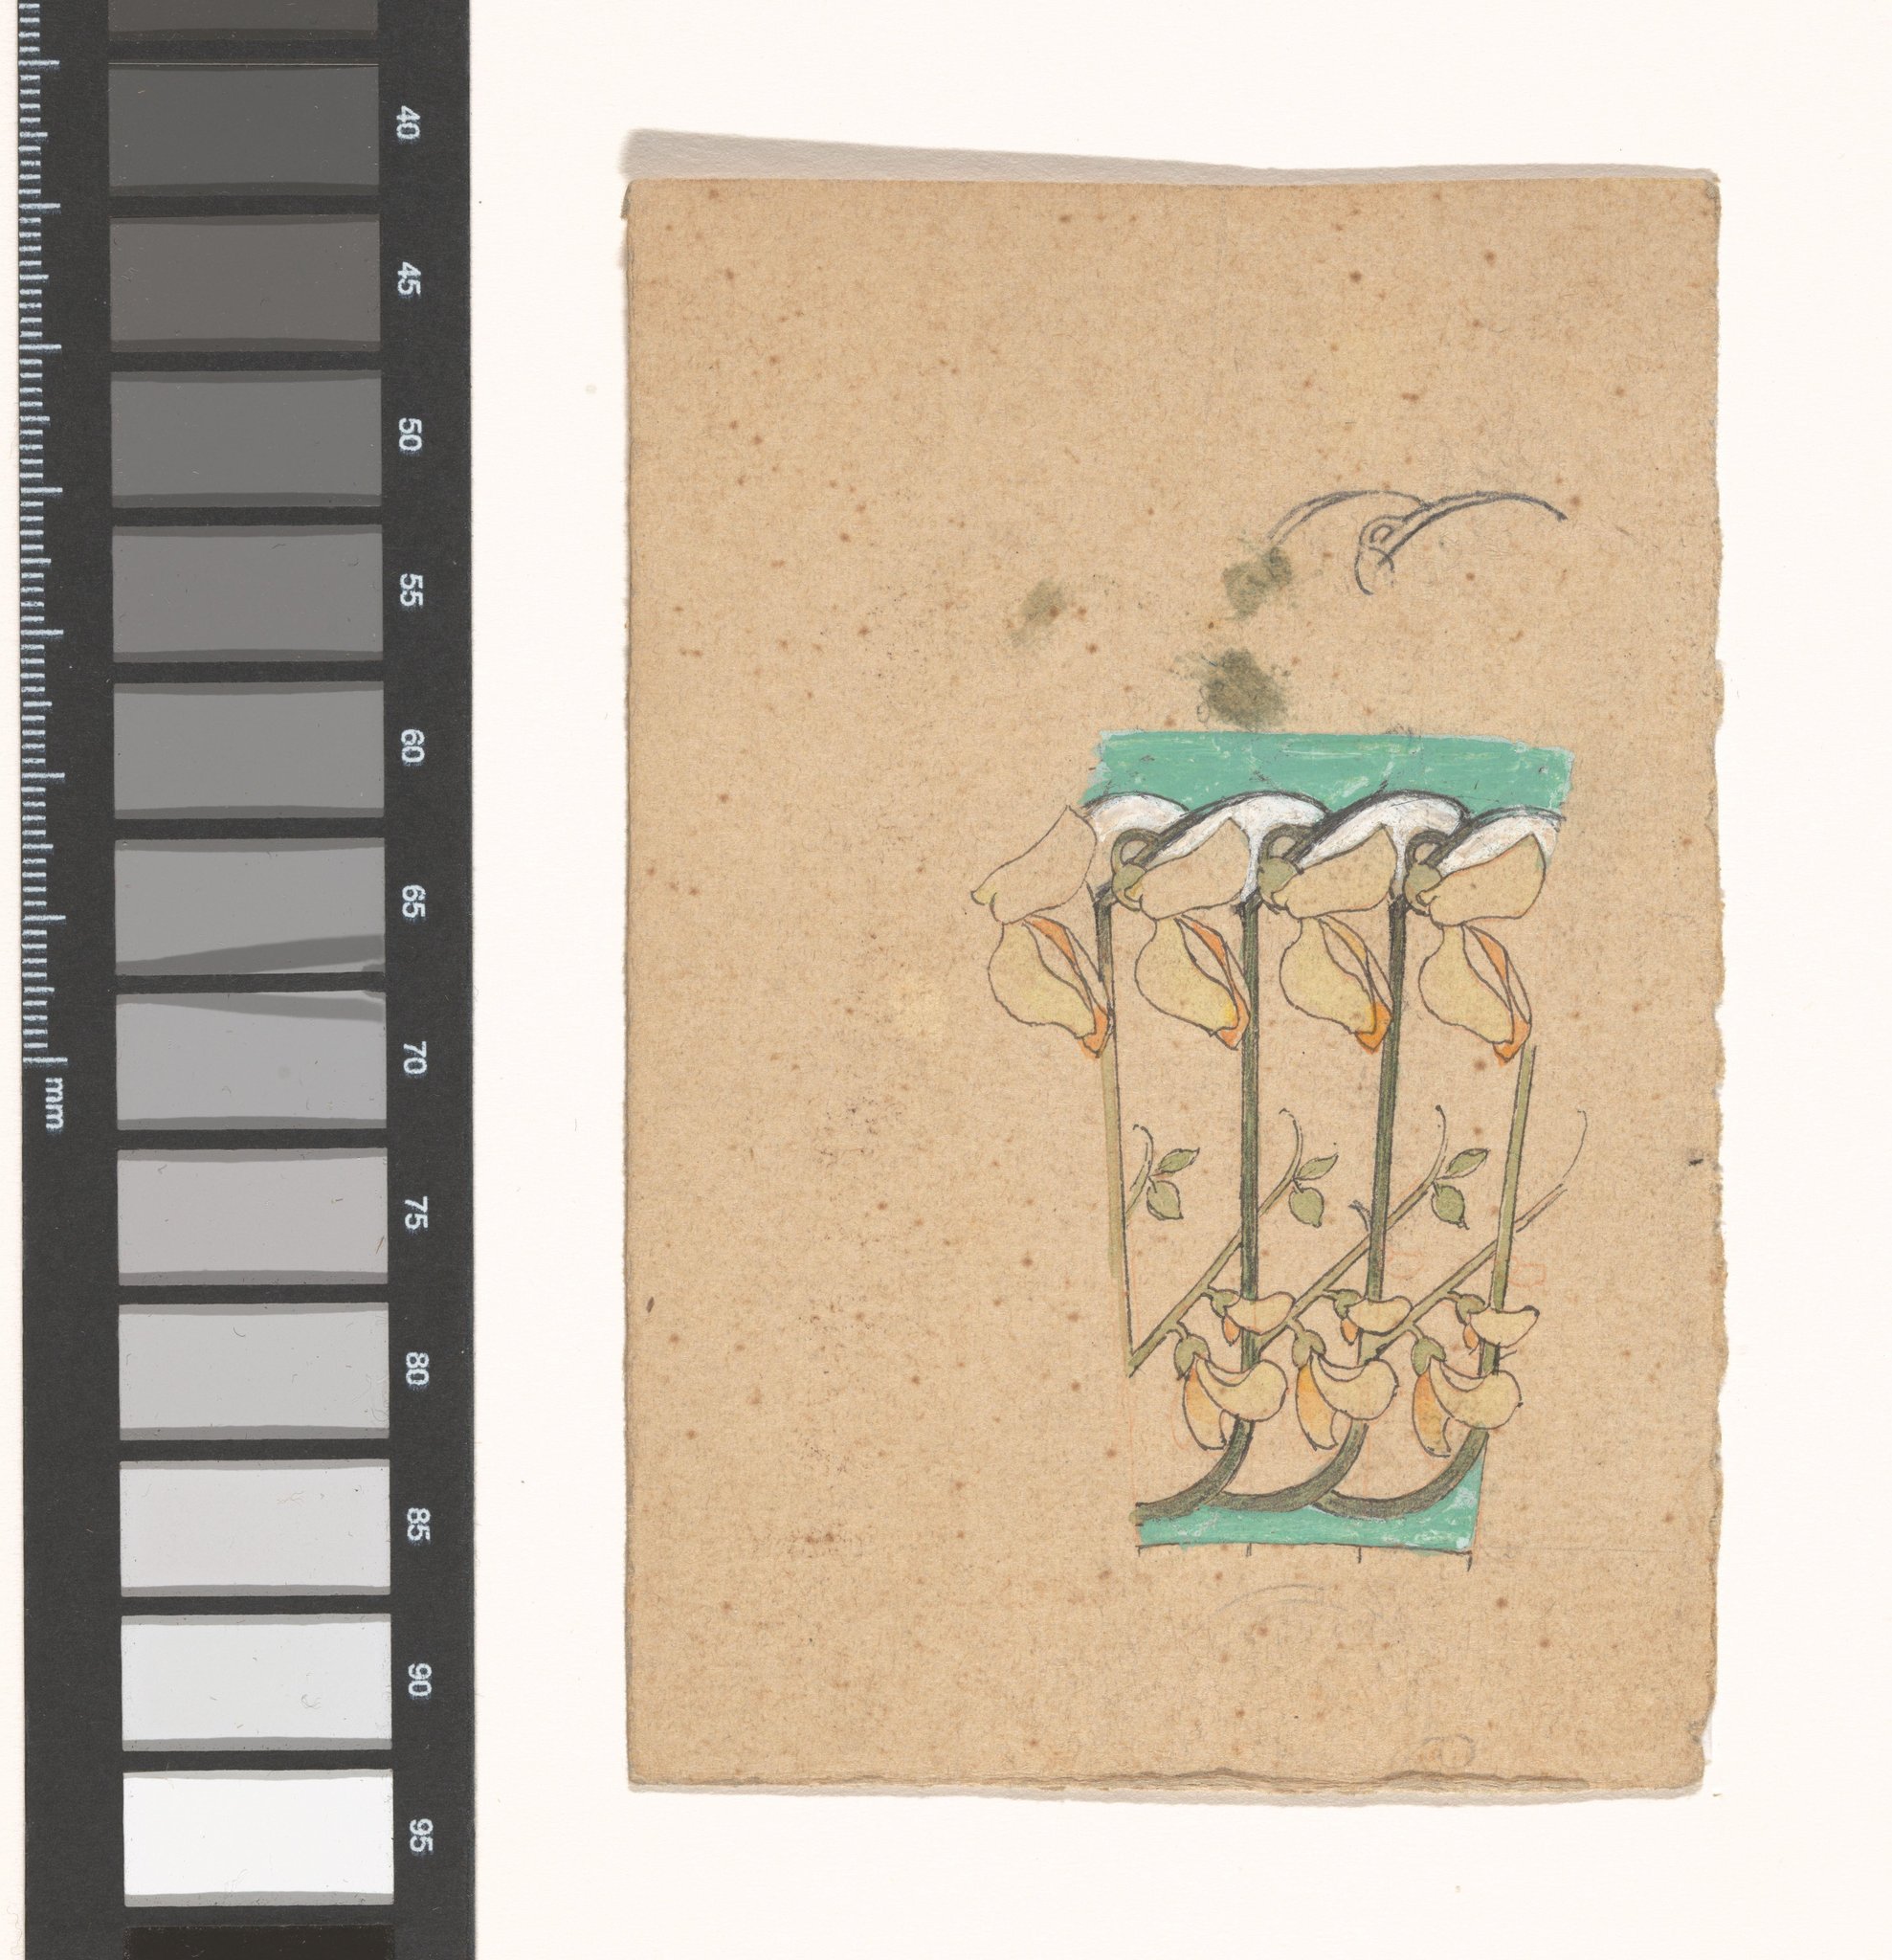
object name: design drawing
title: De beschildering met lathyrus van een knop, met daarboven enkele blaadjes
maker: anatole-alexis fournier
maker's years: 1864-1926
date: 1897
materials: paint, ink, paper, watercolor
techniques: pen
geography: sèvres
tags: flowers: lathyrus, flowers ~ ornament